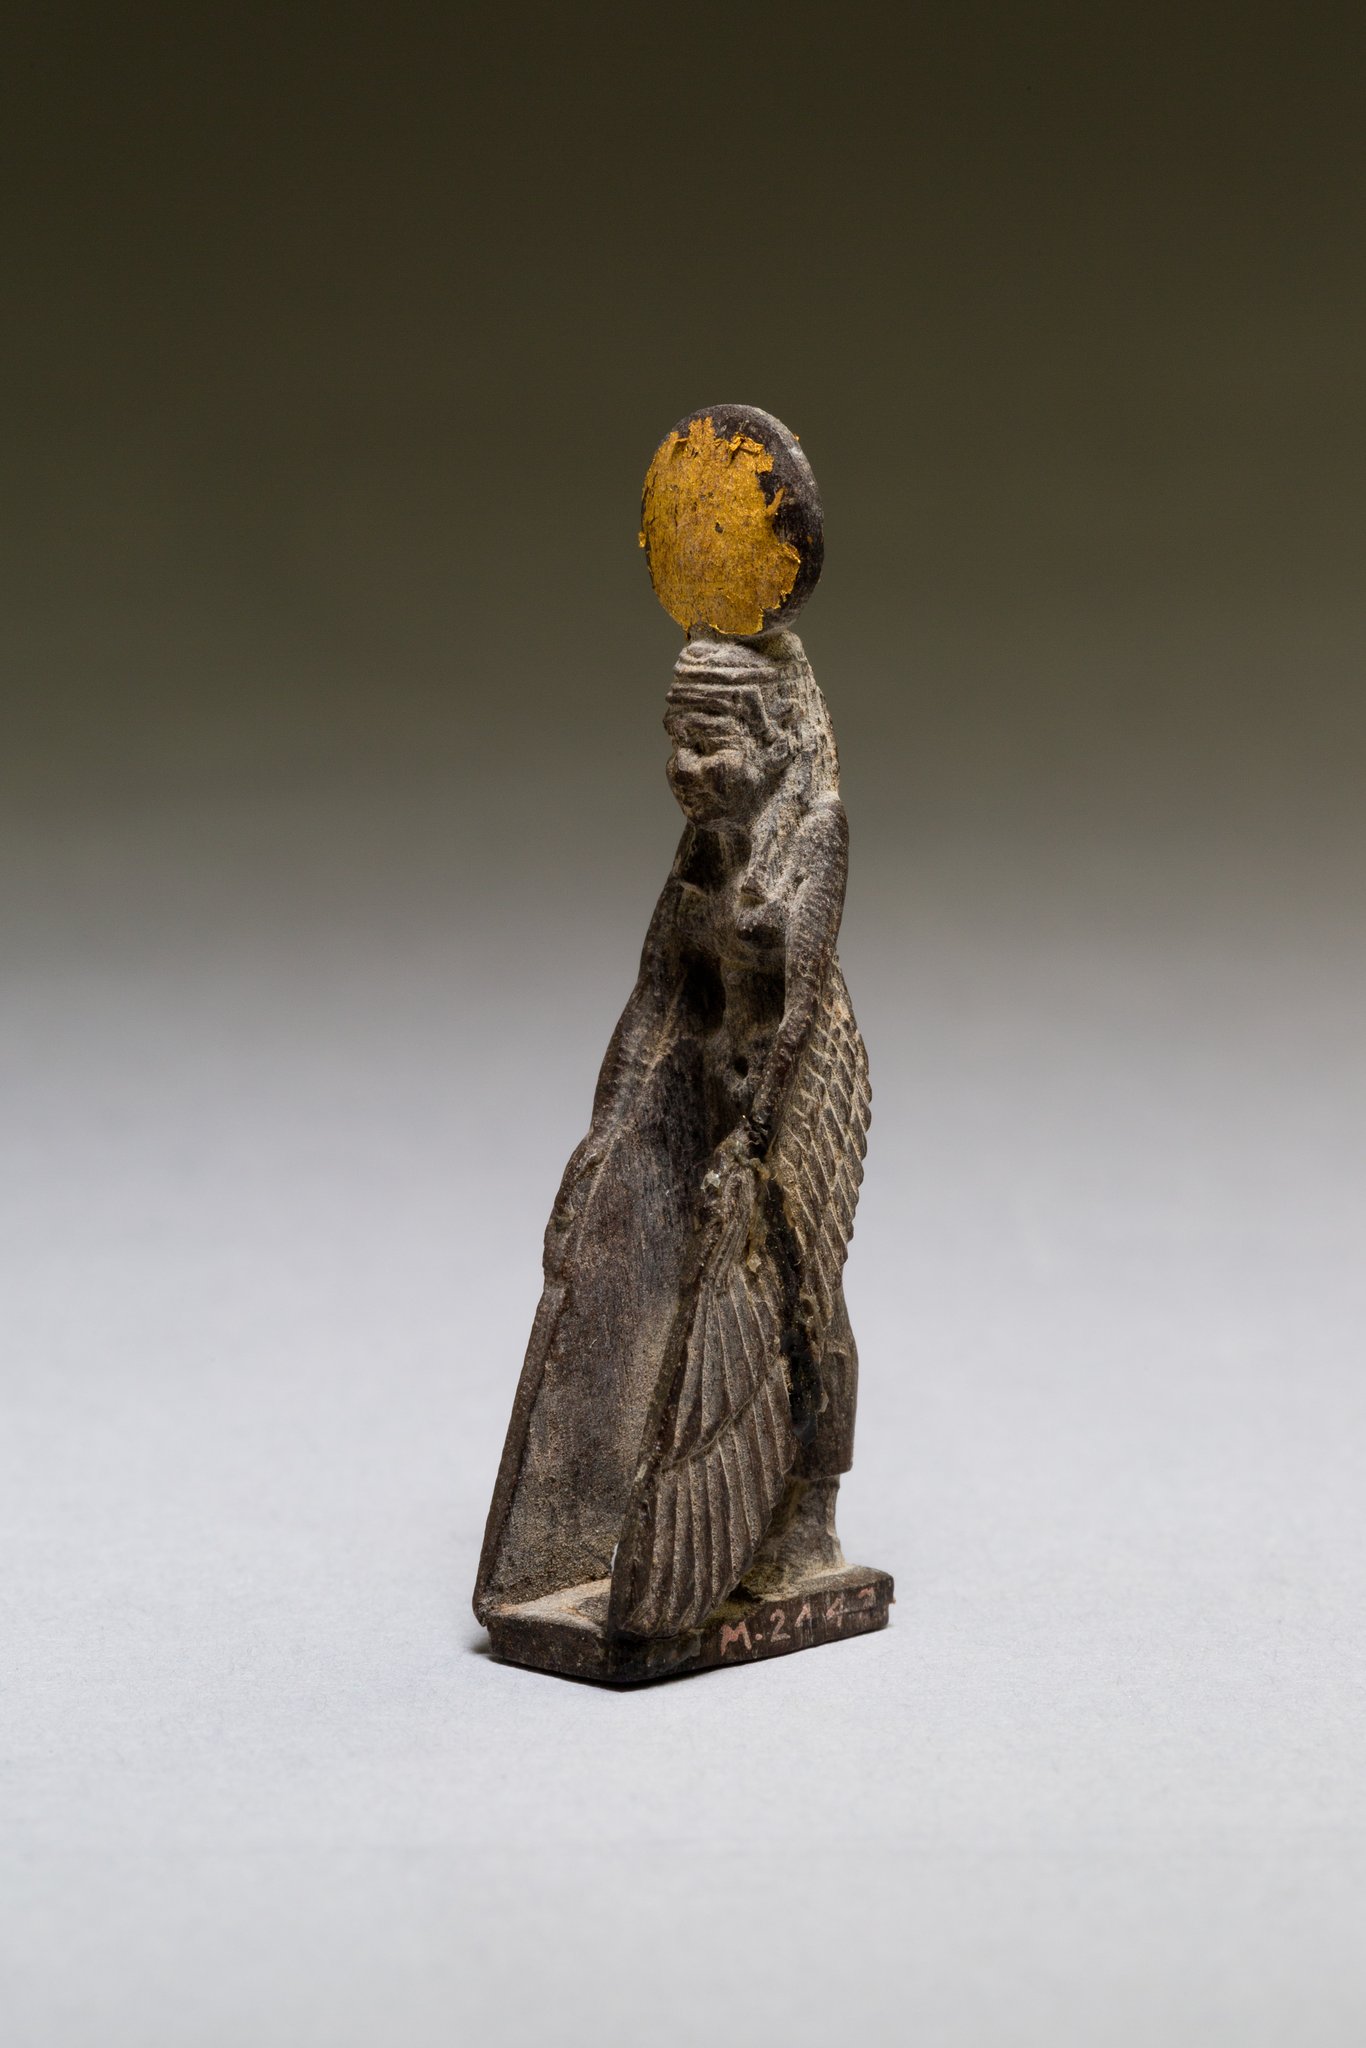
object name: figurine, goddess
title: Goddess with gilded sundisk and wings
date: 664-630 BCE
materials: wood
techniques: gilding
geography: egypt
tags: goddess